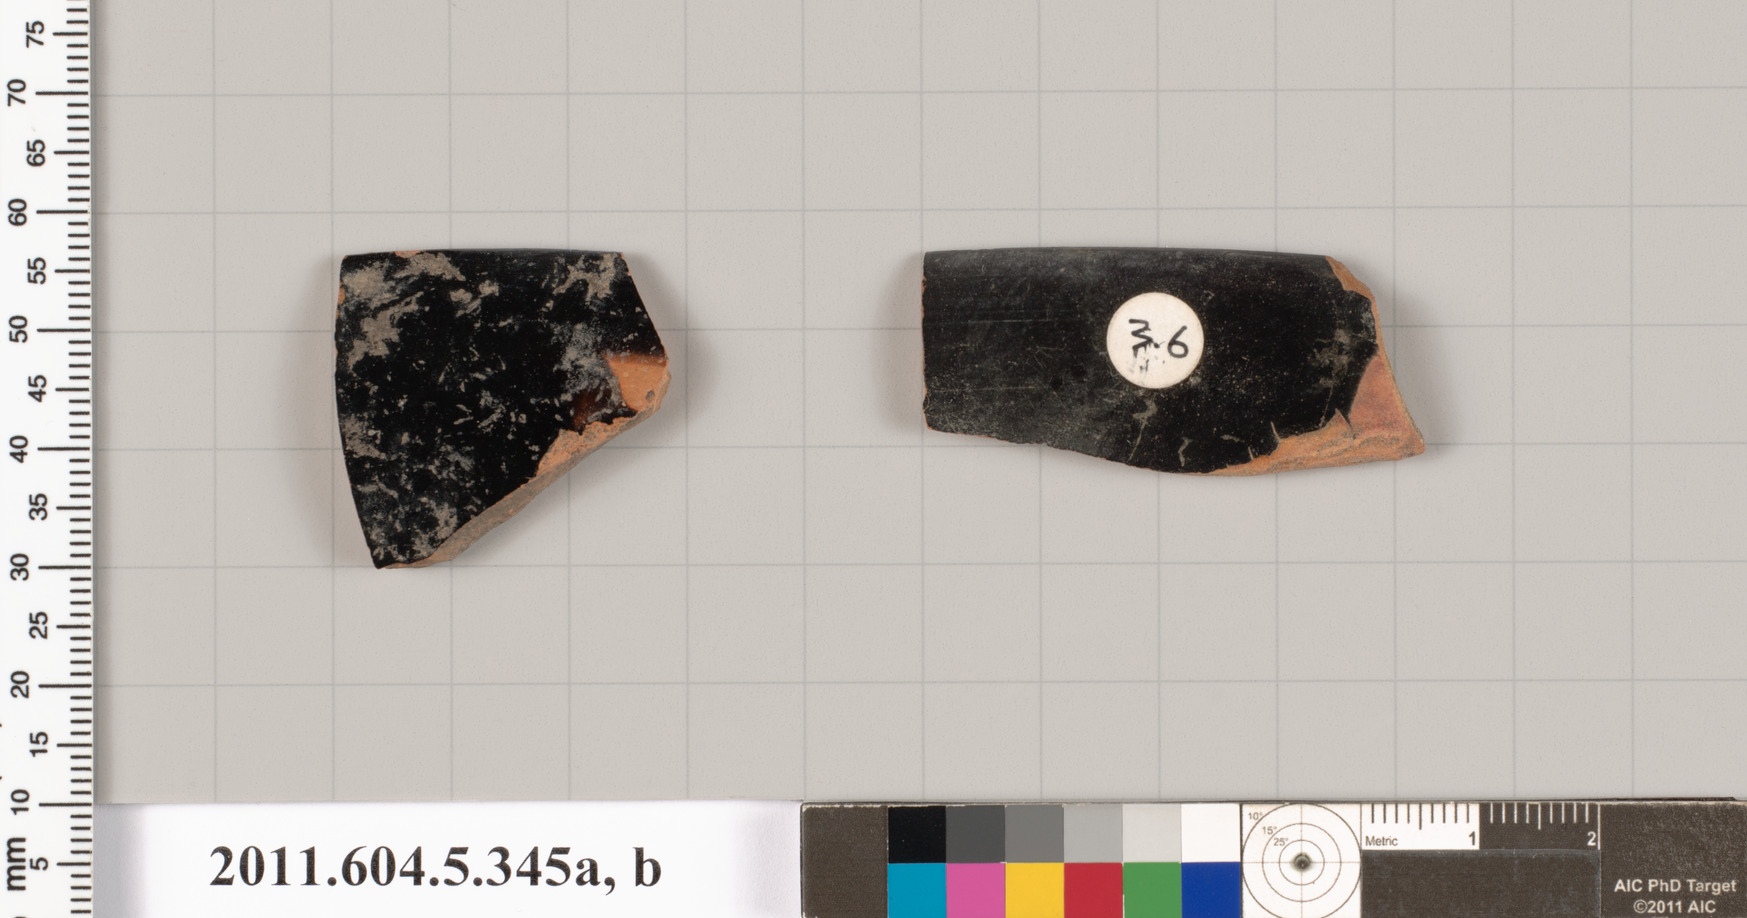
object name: kylix fragment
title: Terracotta rim fragments of kylikes (drinking cups)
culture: greek, attic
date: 600-401 BCE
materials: terracotta